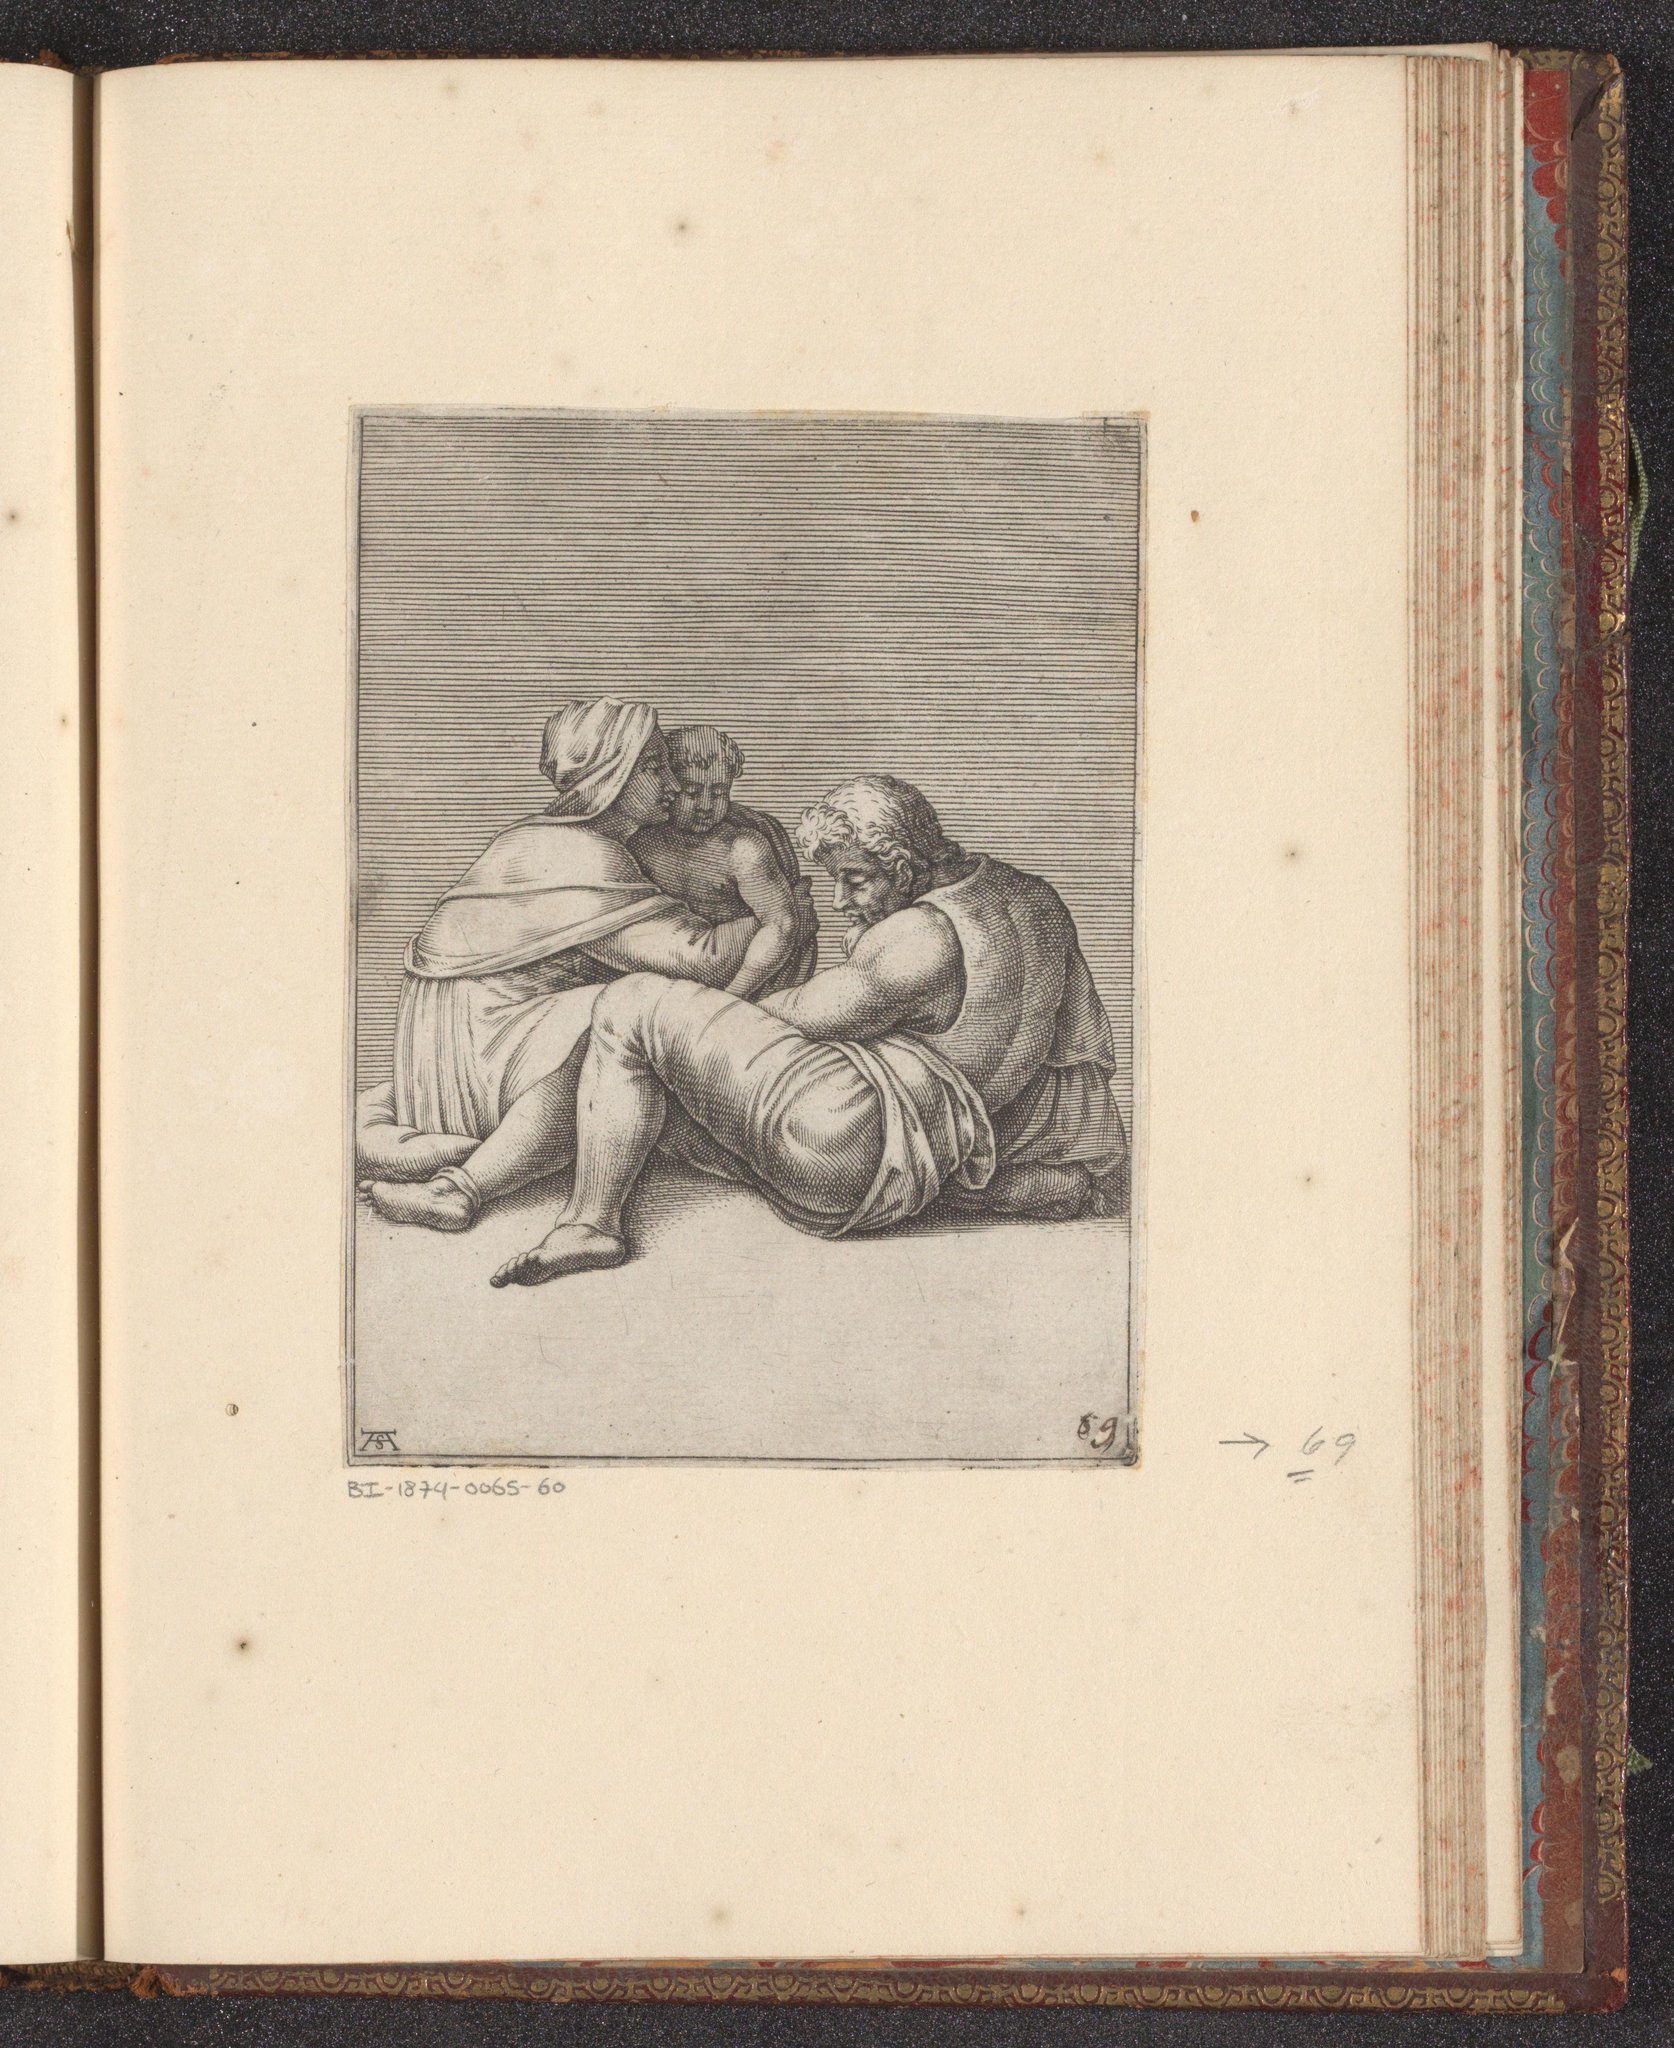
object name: album leaf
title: Man zittend op de grond met vrouw en kind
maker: adamo scultori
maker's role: painter, print maker, sculptor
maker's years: 1530-1585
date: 1585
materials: paper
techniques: engraving, intaglio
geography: italy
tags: sitting on the ground, mother and child(ren), woman and child(ren) (family group)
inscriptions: number: ‘59’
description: Deze prent maakt deel uit van een serie bestaande uit een titelprent en 72 prenten naar schilderingen door Michelangelo in de Sixtijnse Kapel in het Vaticaan.